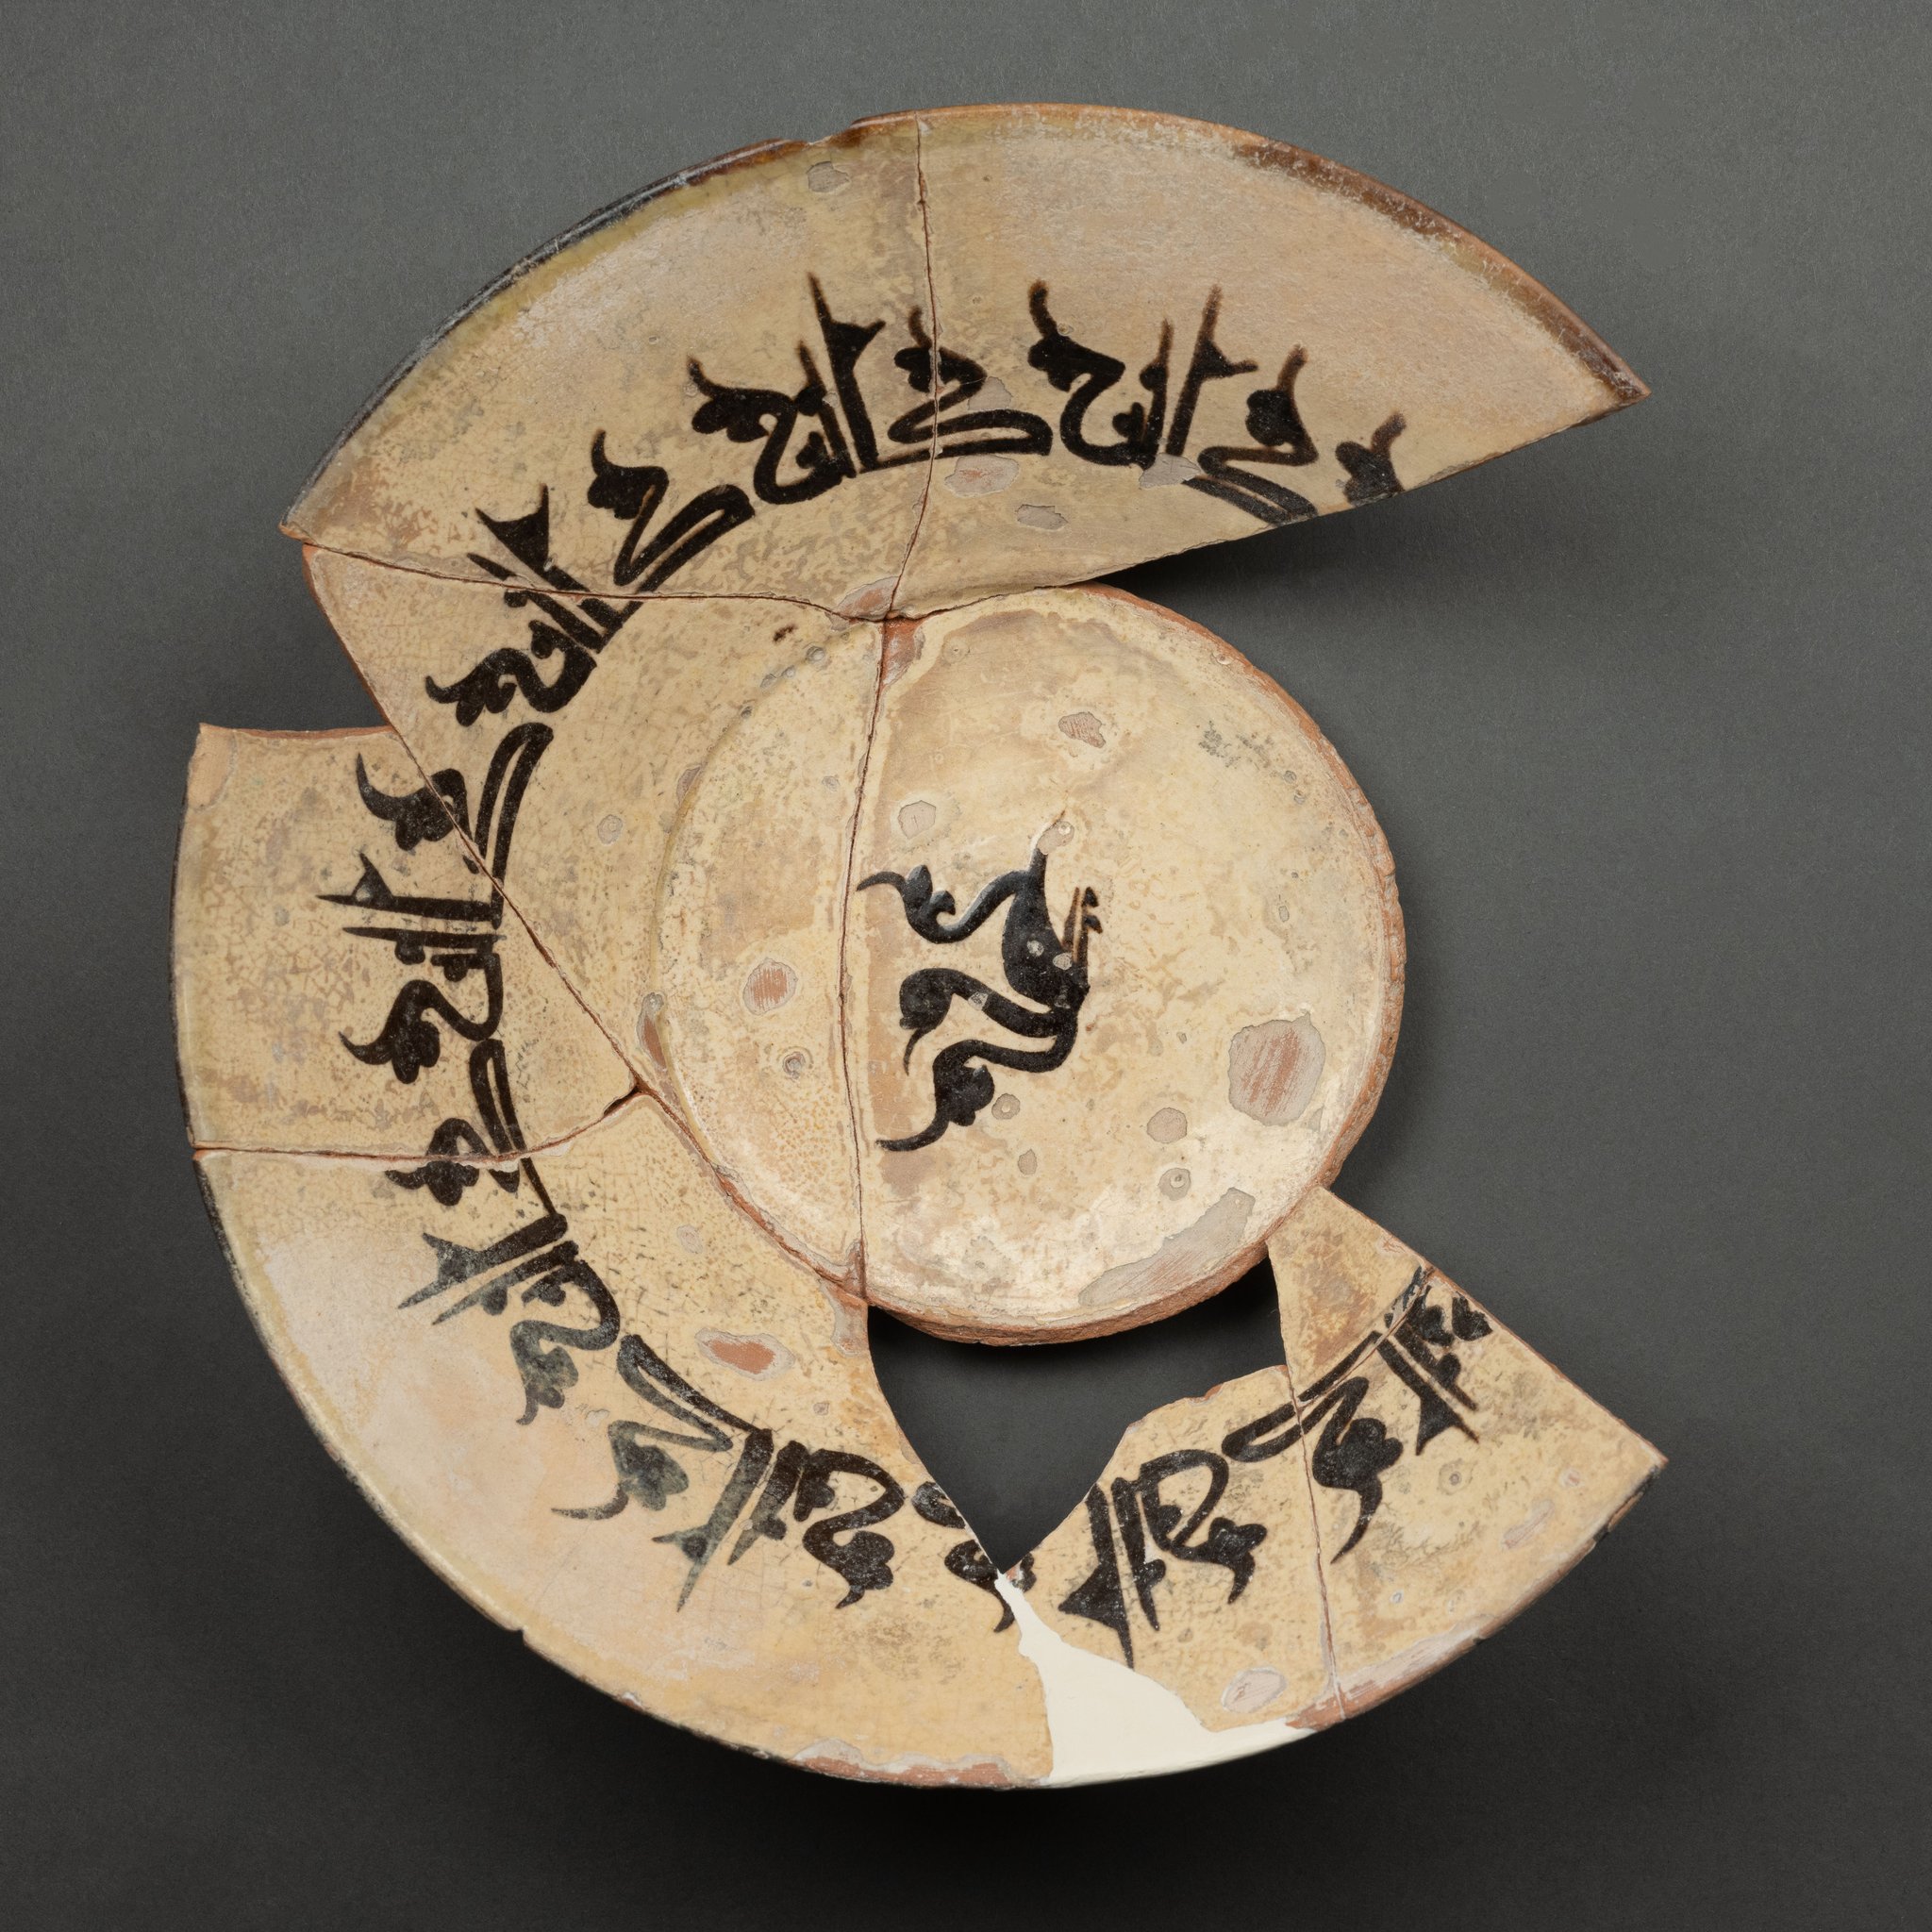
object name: bowl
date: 801-1000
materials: earthenware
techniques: glazing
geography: iran